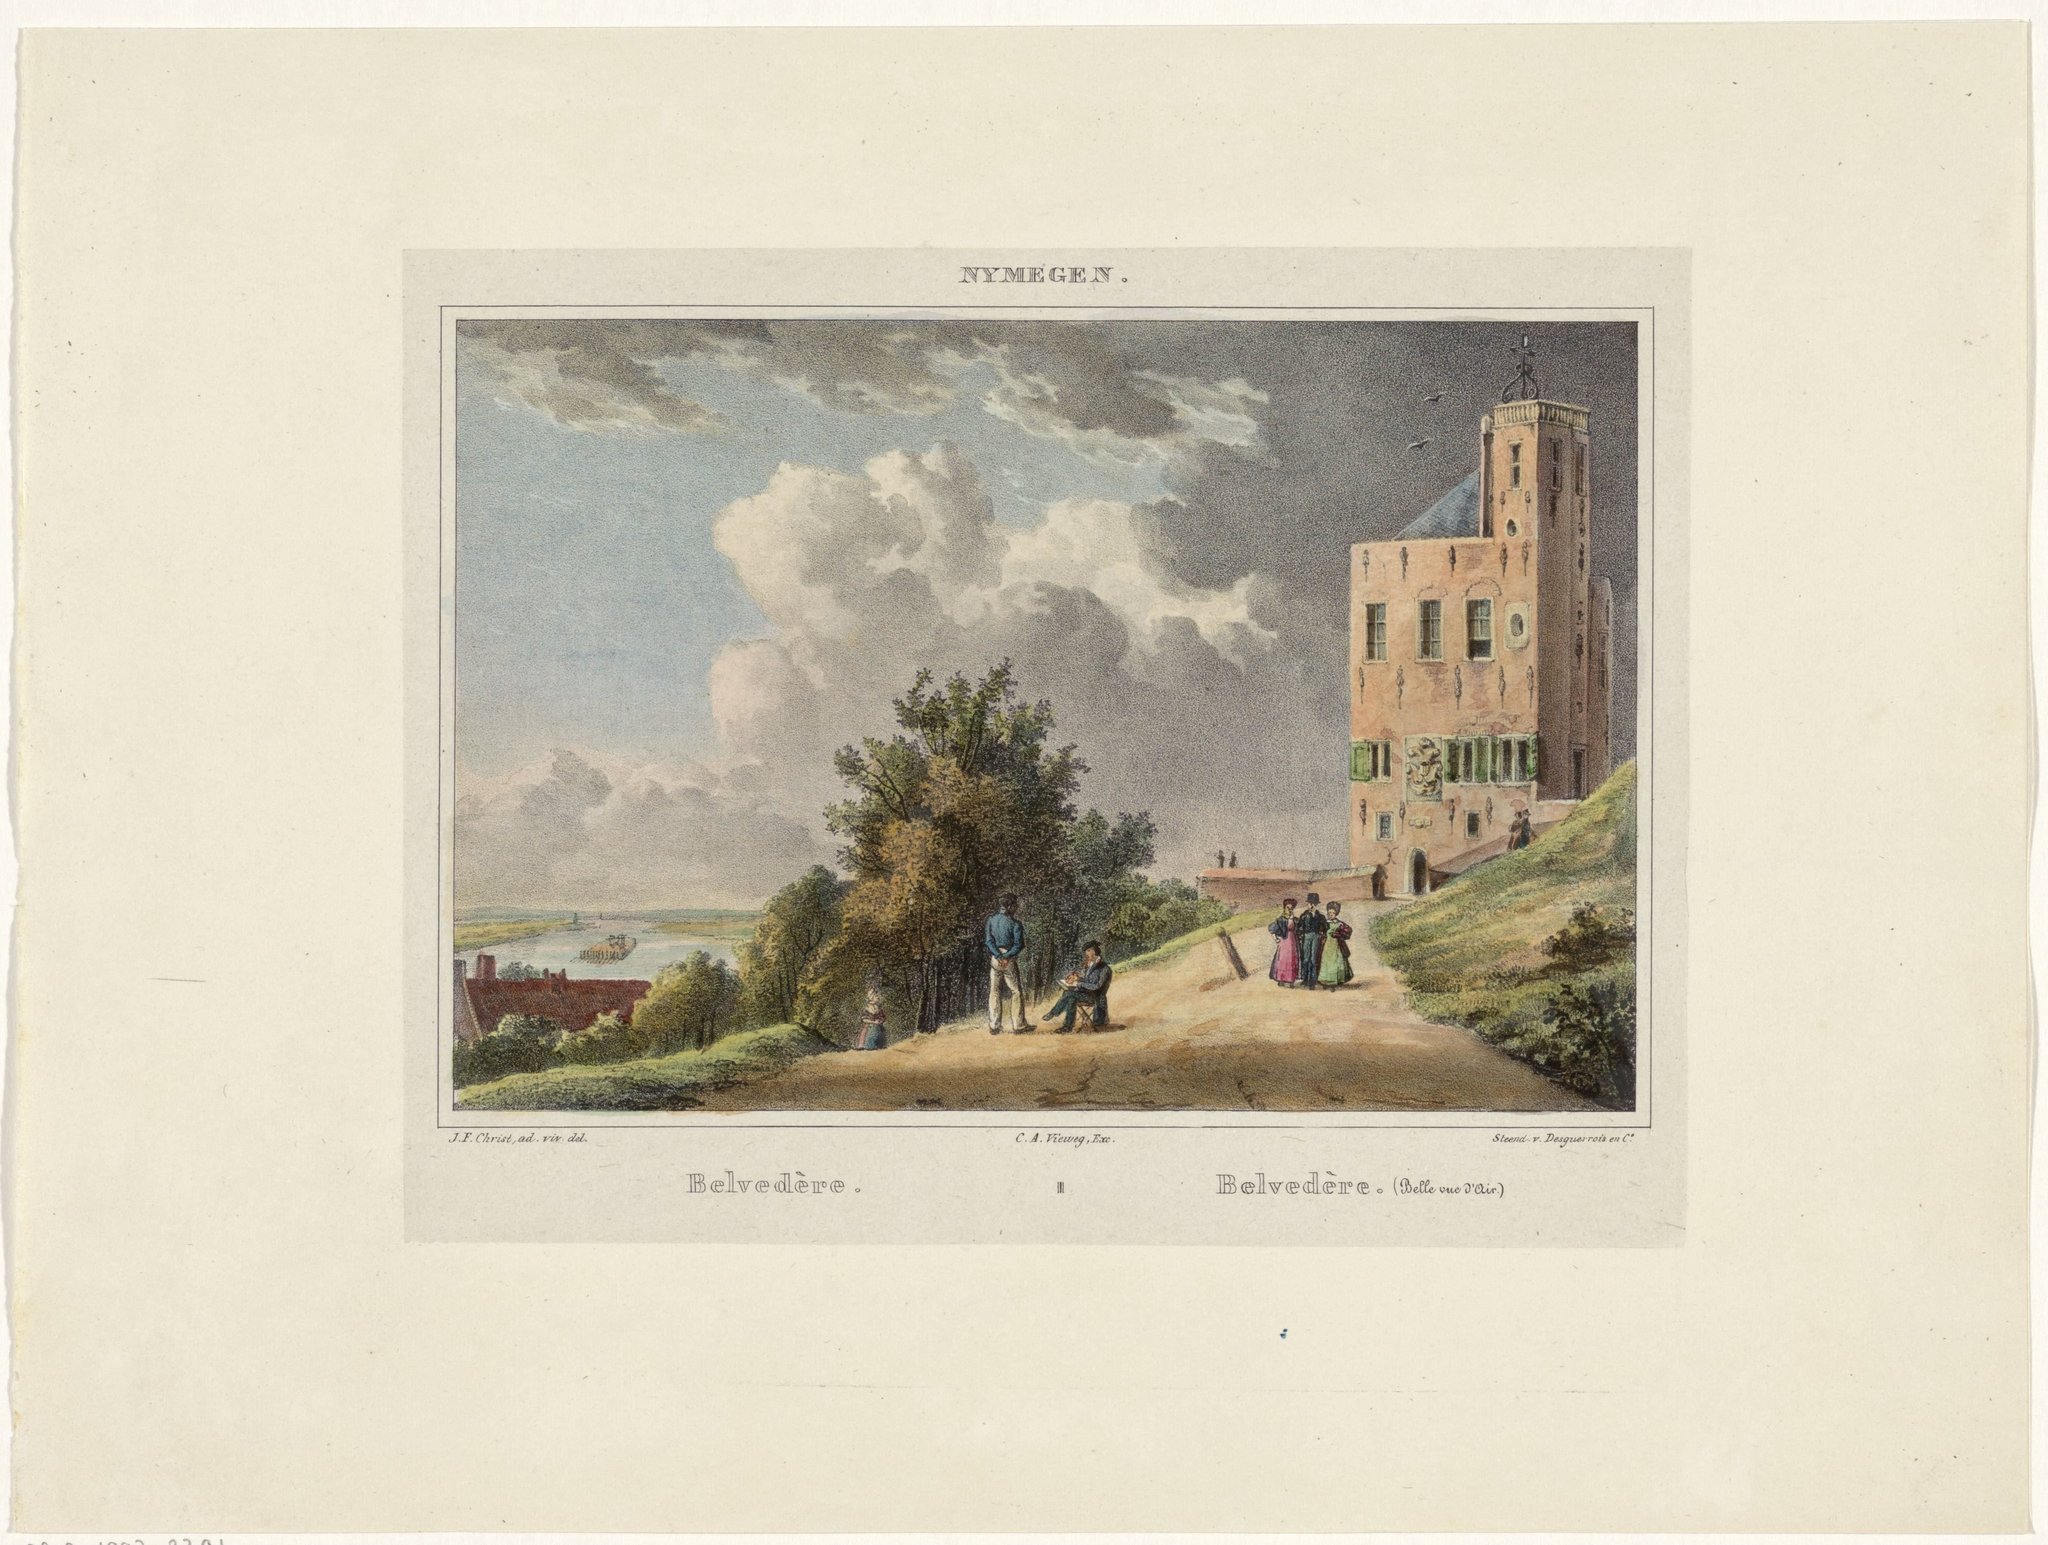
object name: print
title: Belvedère lll Belvedère (Belle vue d'Air)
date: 1834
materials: paper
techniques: hand coloring, lithograph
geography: nijmegen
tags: city-view, and landscape with man-made constructions, towers ~ fortified city, landscape with tower or castle (+ city(-scape) with figures, staffage), nijmegen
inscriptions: collector's mark: Lugt 2228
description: Het Belvédère ligt aan het einde van een landweg. Links achter de bomen de rivier Het Meertje. Op de landweg lopen drie figuren gearmd. In het midden zit een tekenaar te werken met naast hem een staande man. Deze prent maakt deel uit van een serie over Nijmegen.